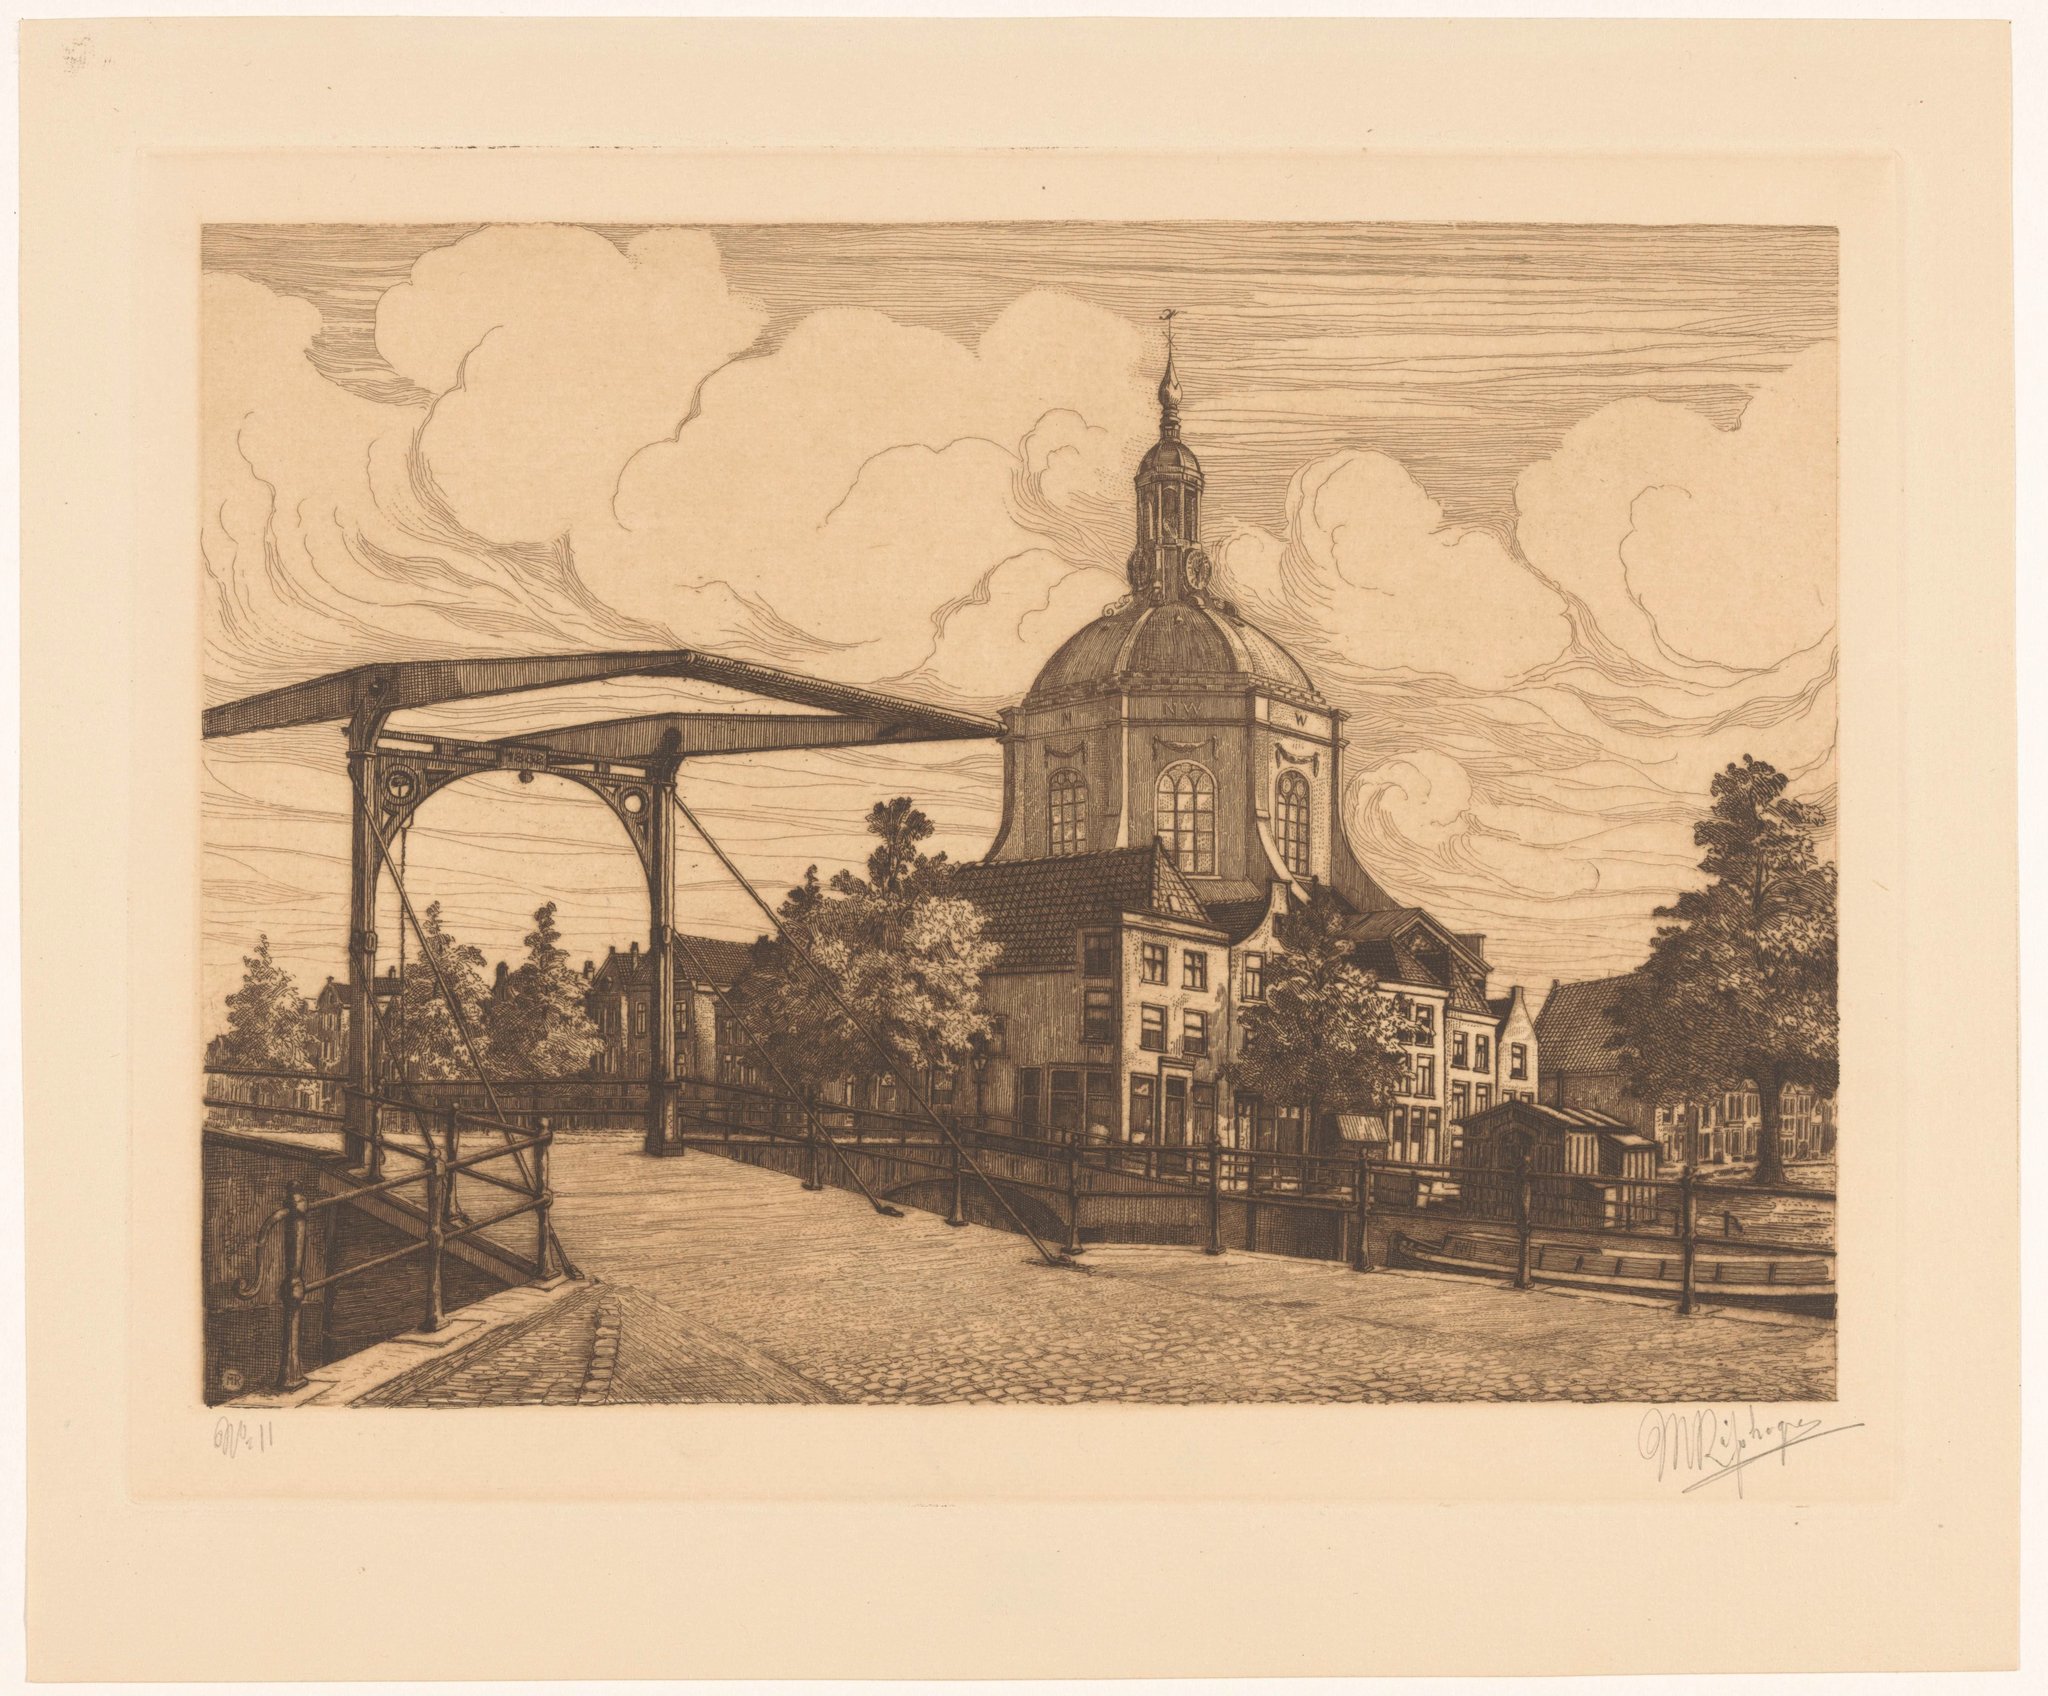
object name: print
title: Stadsgezicht met ophaalbrug en Marekerk in Leiden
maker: m. riphagen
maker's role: print maker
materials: paper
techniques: etching, intaglio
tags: bascule bridge, parts of church exterior and annexes: dome, bridge in city across river, canal, etc.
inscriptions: collector's mark: Lugt 2760, collector's mark: Lugt 2166